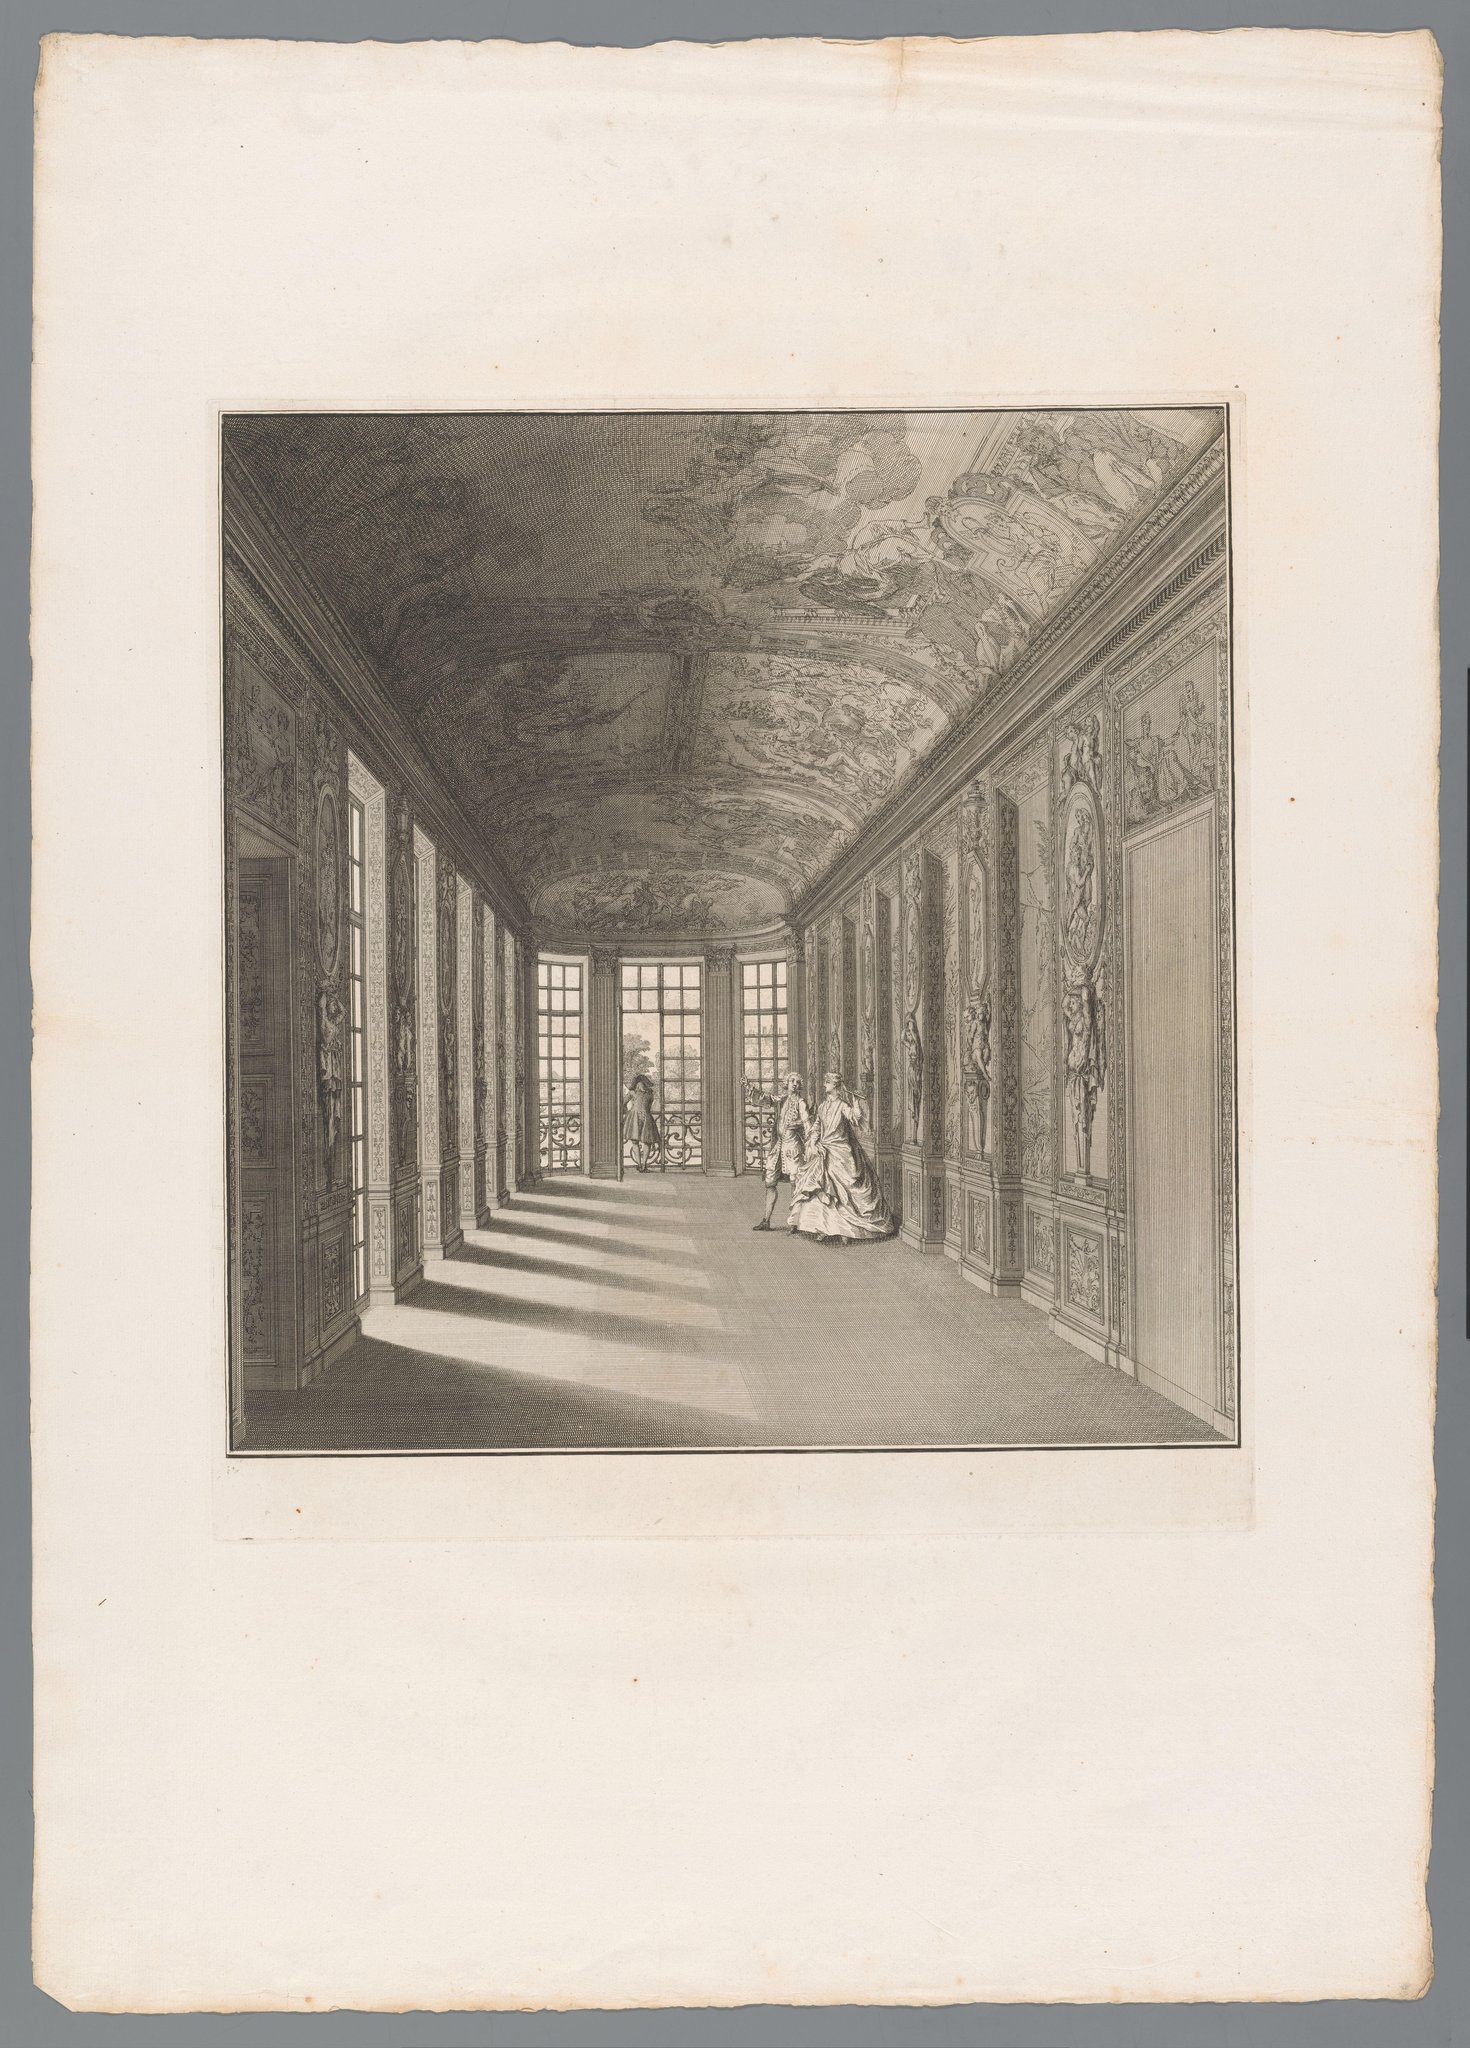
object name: print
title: Les peintures de Charles le Brun et d'Eustache Le Sueur qui sont dans (...) la maison du Président Lambert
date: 1713-1733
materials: paper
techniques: engraving, etching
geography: paris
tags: gallery (spacious corridor)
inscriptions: collector's mark: Lugt 2228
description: Galerij van Hercules in het Hôtel Lambert te Parijs. Het plafond van de galerij is geschilderd door Charles LeBrun en toont de Apotheose van Hercules. Een dame en een heer bekijken het plafond. Op het balkon staat een man, op de rug gezien. Prent maakt deel uit van een serie prenten naar de schilderijen in het Hôtel Lambert te Parijs.